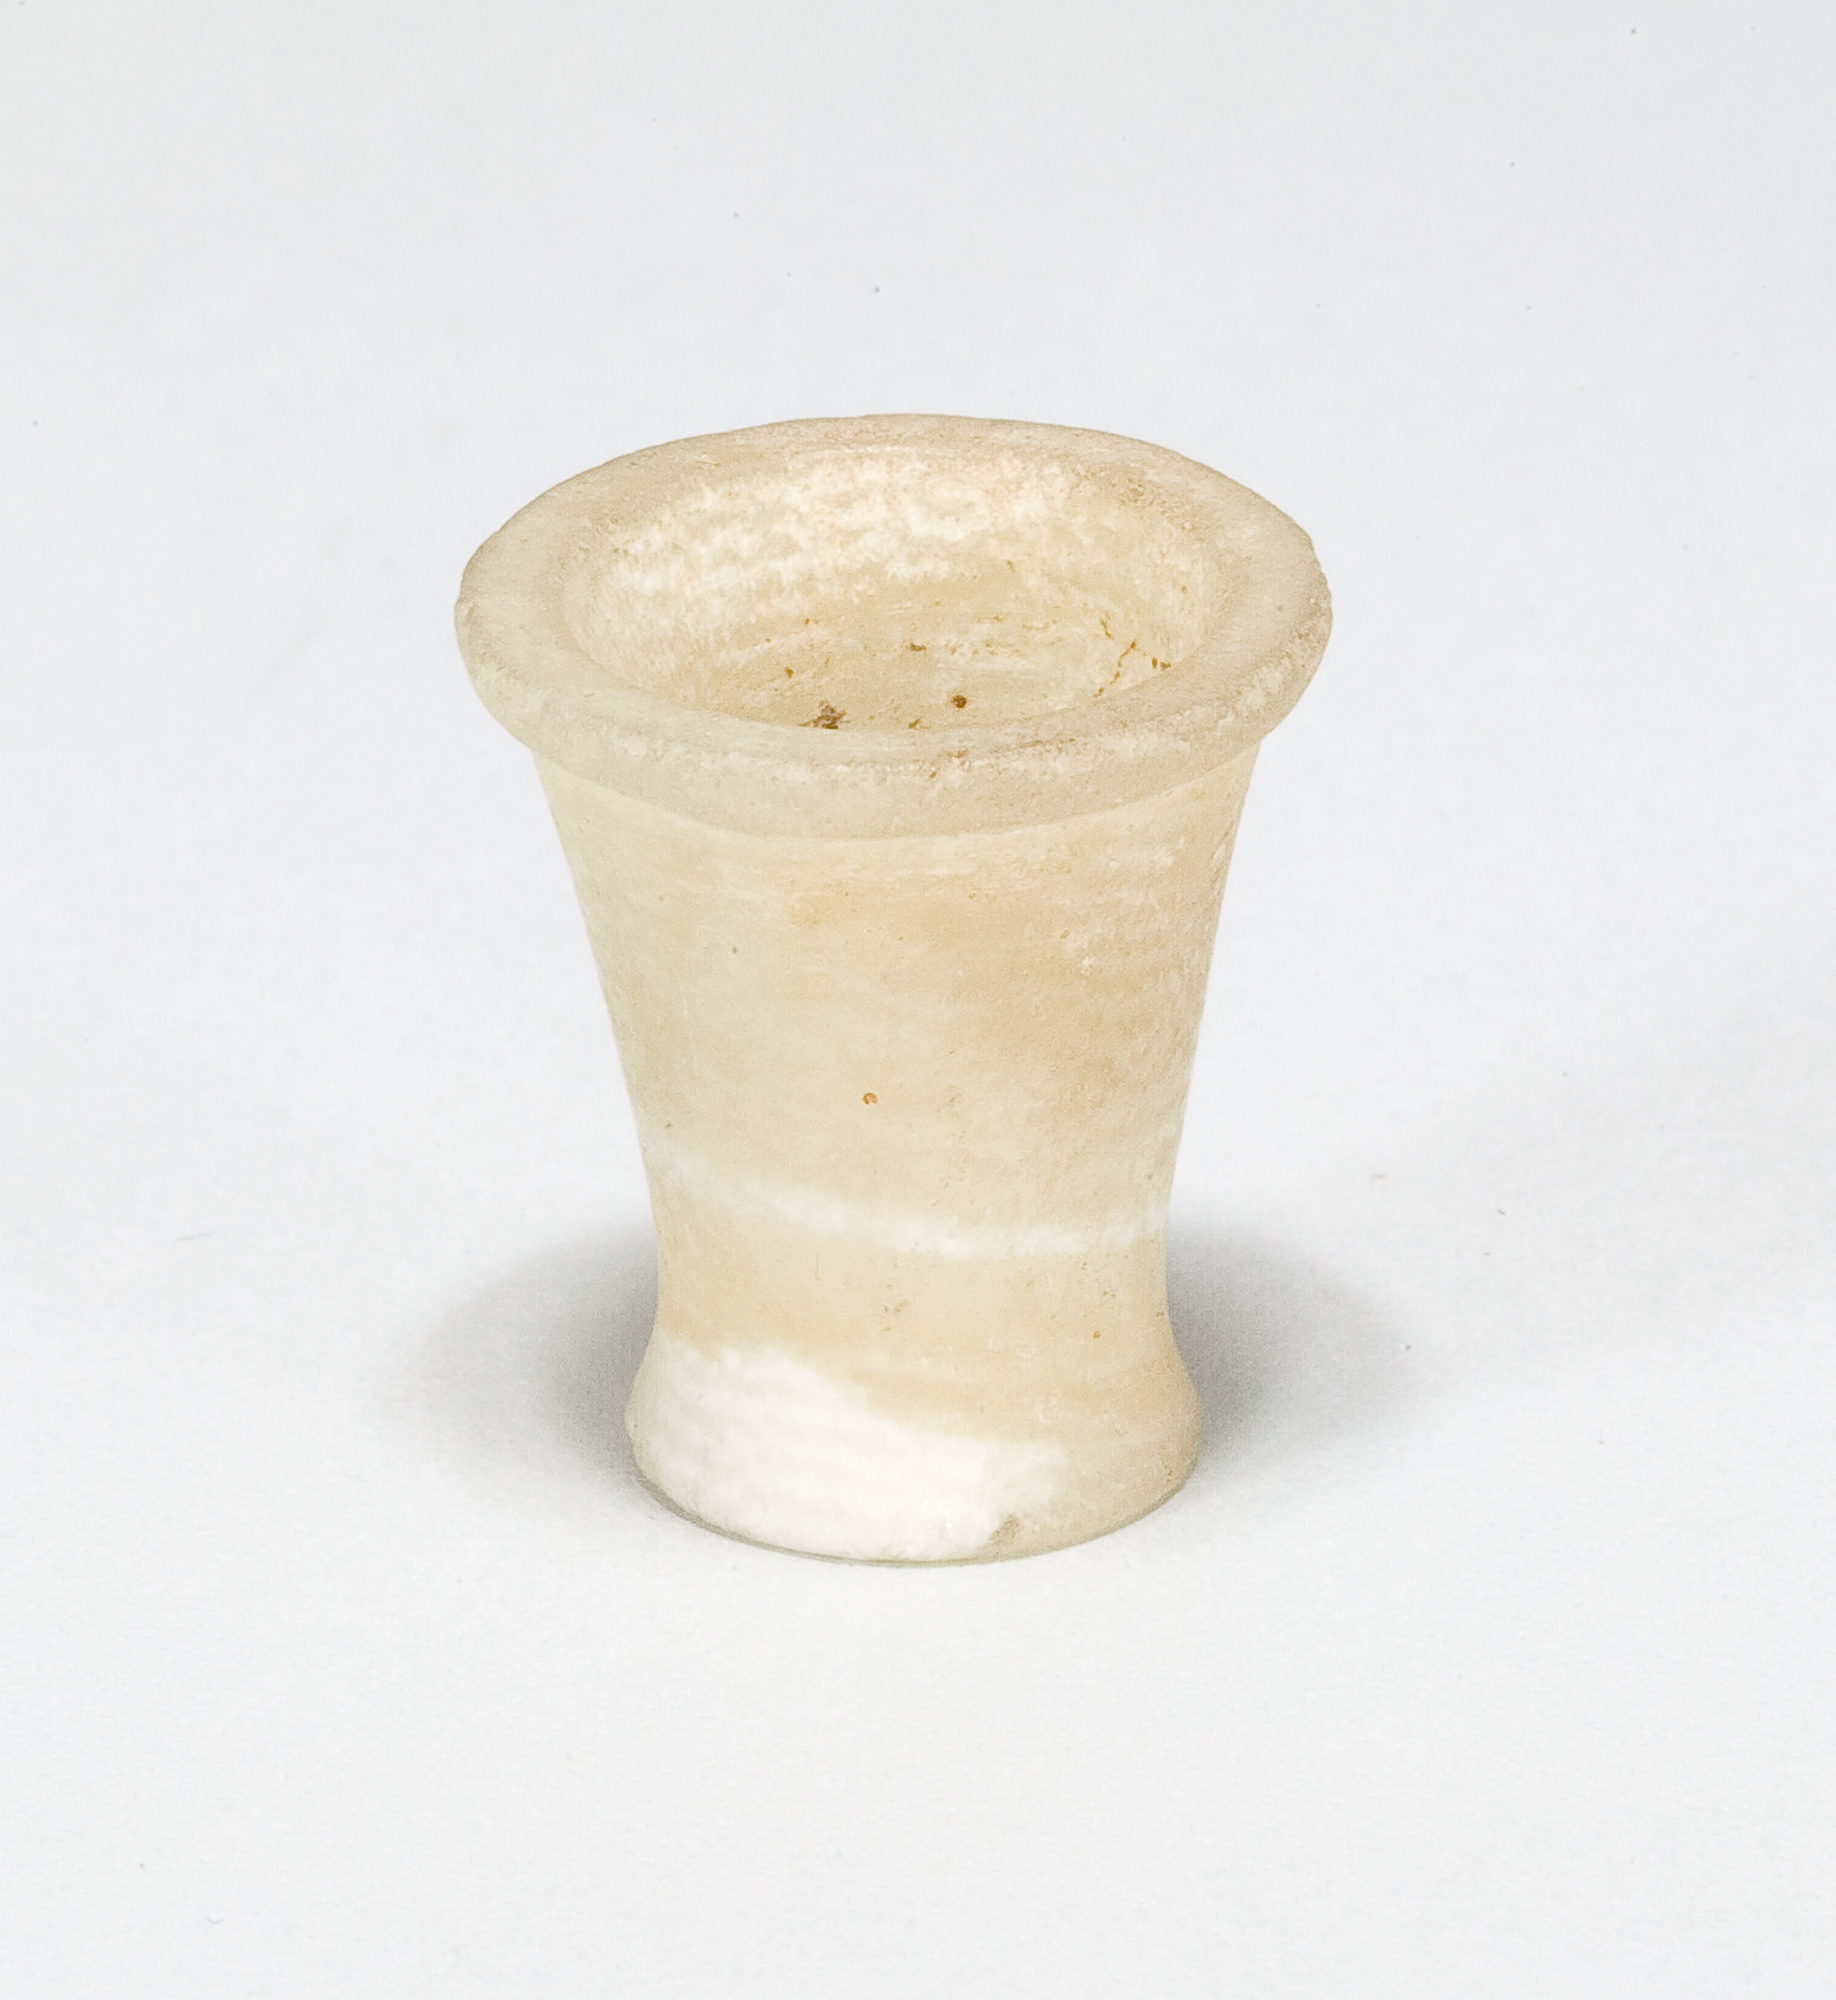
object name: toilet vase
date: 1850-1775 BCE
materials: stone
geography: egypt